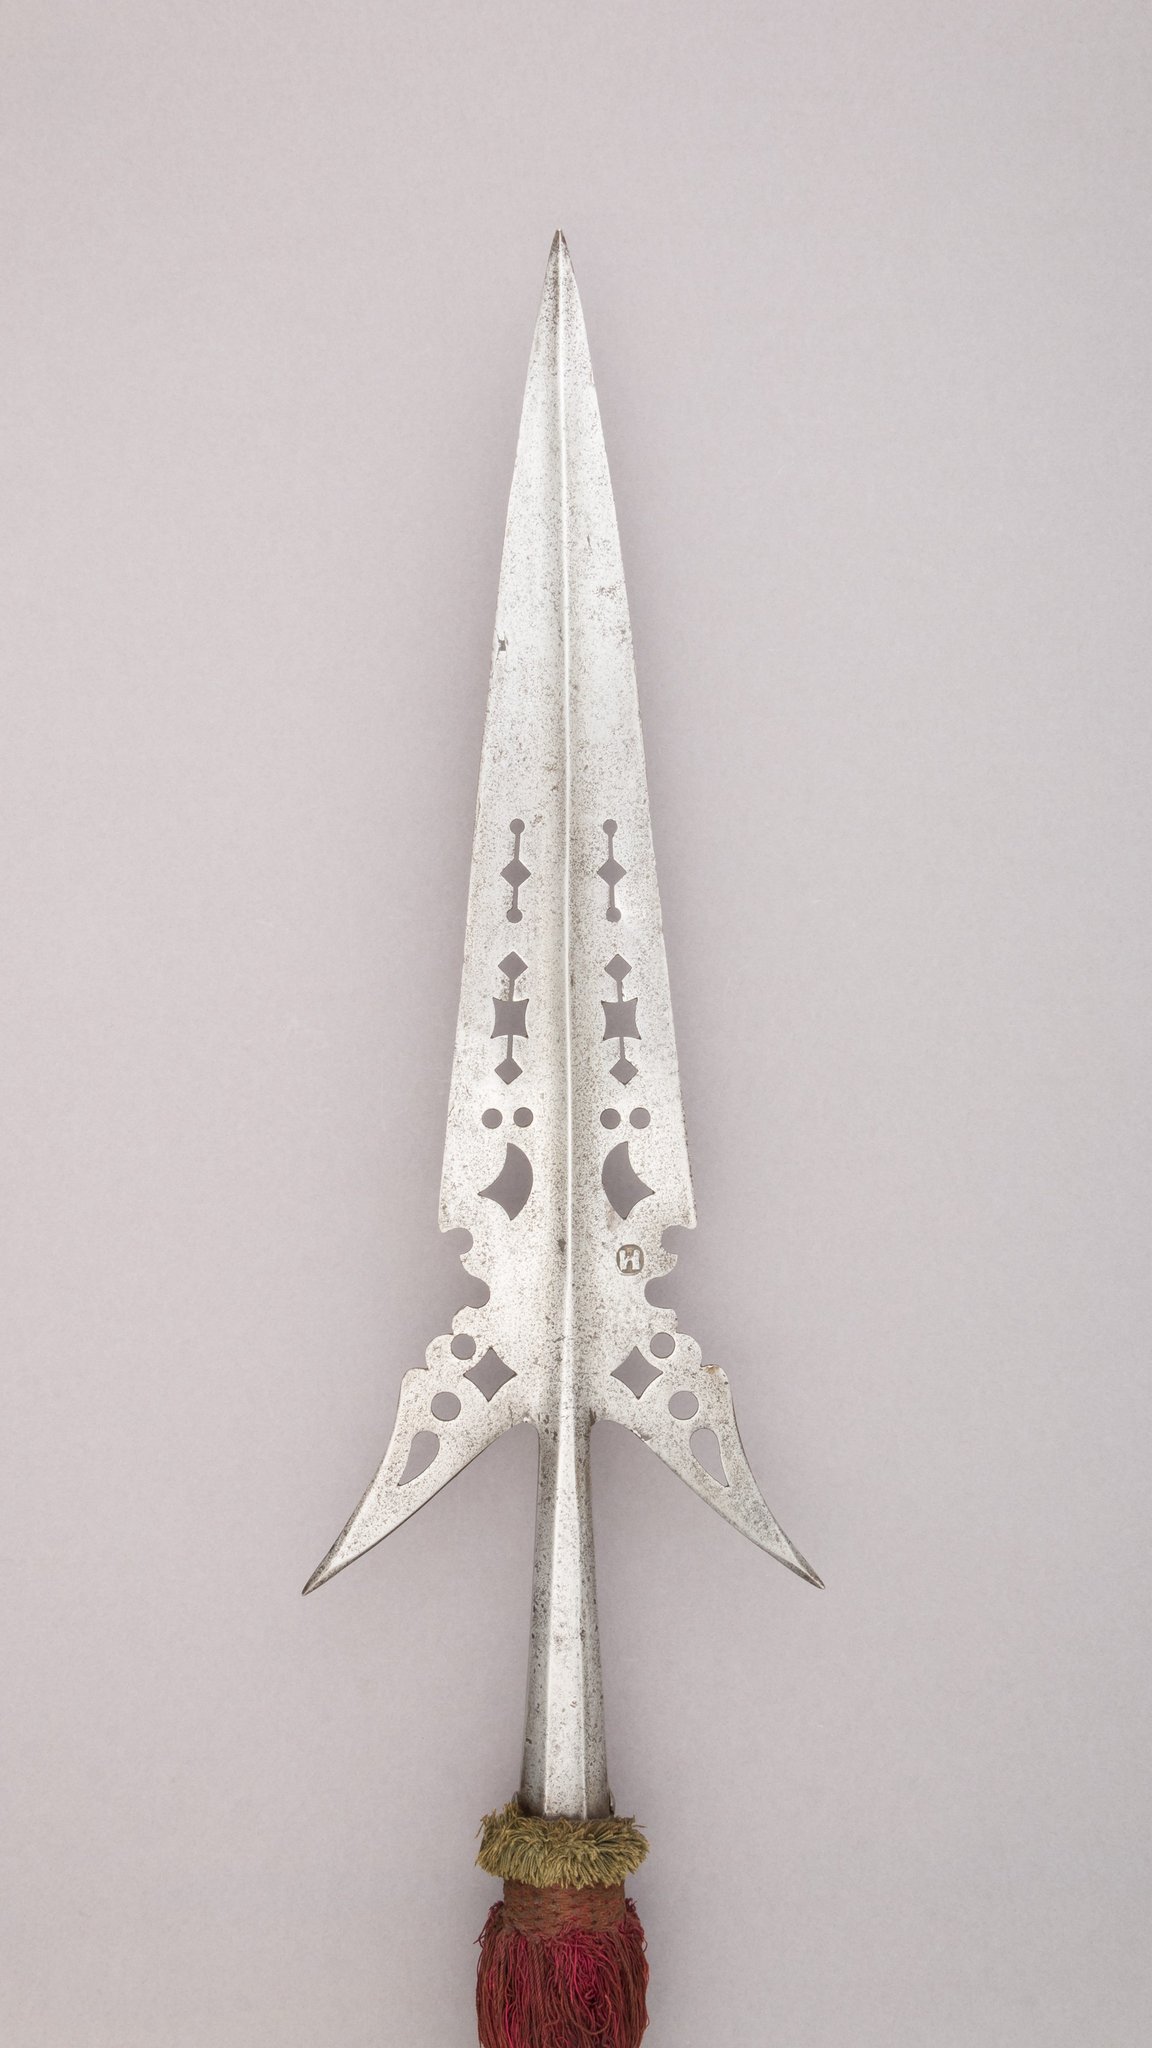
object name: partisan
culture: british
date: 1501-1600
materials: steel, textile, wood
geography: england